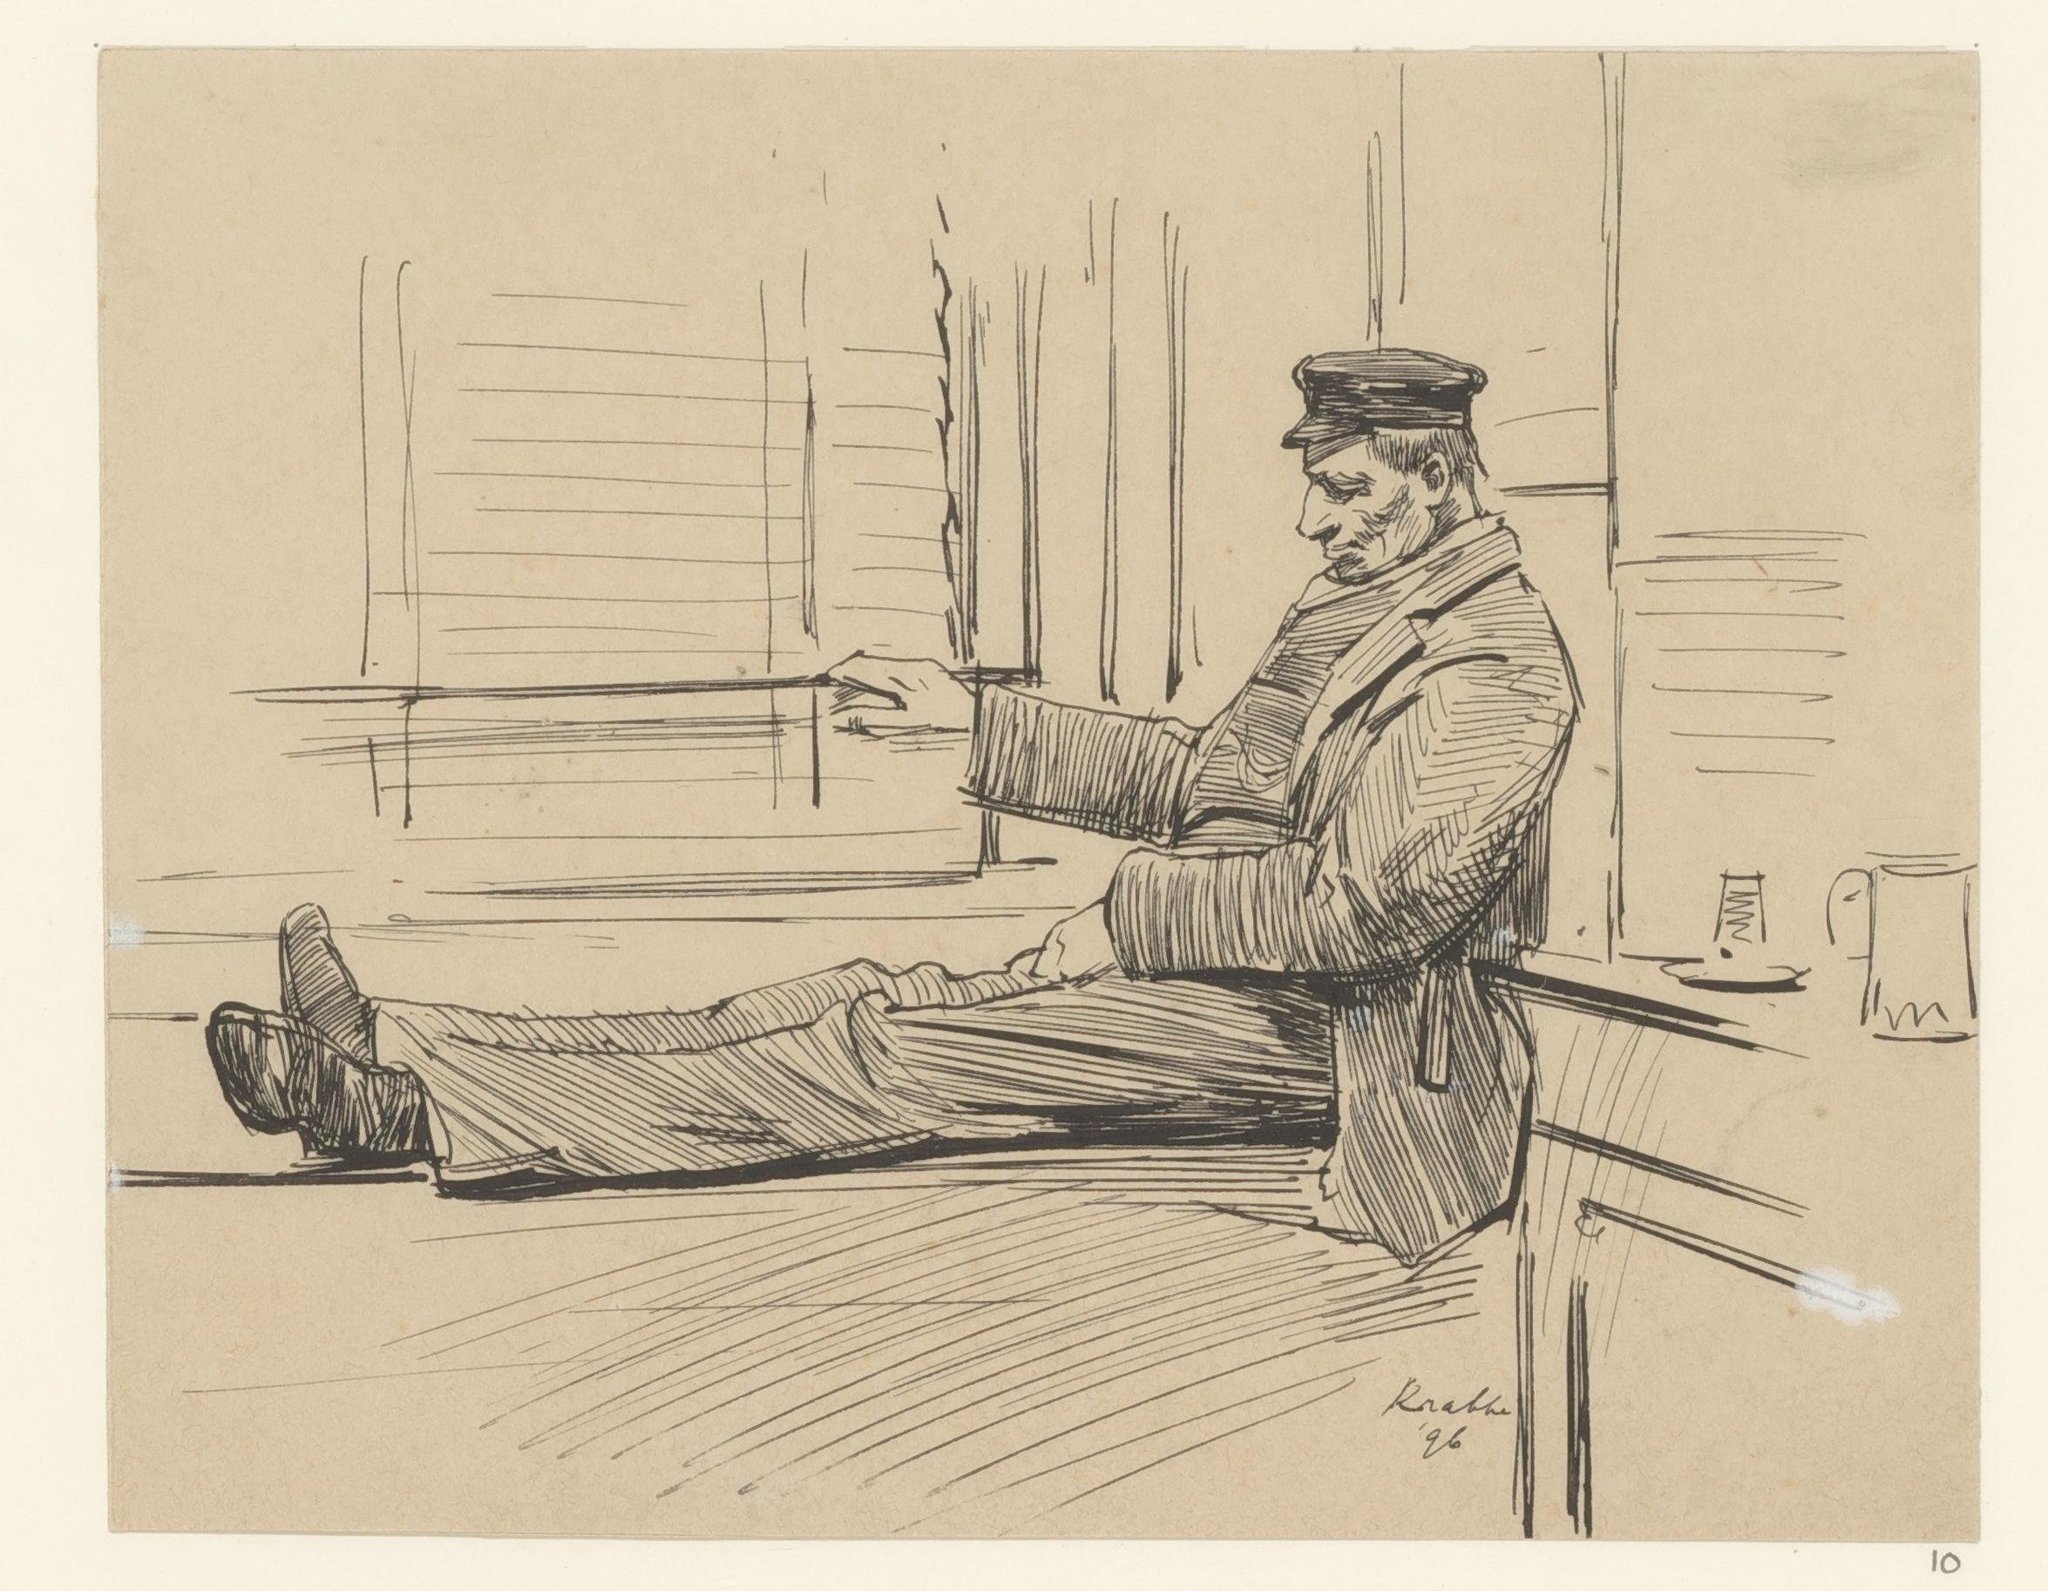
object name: drawing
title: Op maandag avond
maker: heinrich m. krabbé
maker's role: draughtsman, print maker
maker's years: 1868-1931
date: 1896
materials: paint, ink, paper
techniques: brush, pen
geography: netherlands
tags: pigeons (racing), doves, pigeons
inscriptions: collector's mark: Lugt 1641, collector's mark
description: Een man languit zittend bij een venster met een neergelaten jaloezie. Waarschijnlijk een duivenmelker die wacht op de terugkeer van zijn duiven na een wedstrijd in het weekend. In de Amsterdamse Jordaan. Onderwerpsrubrieken binnen de Atlas Zeden en Gewoonten: Spel en Vermaak; Duiven in de Jordaan.